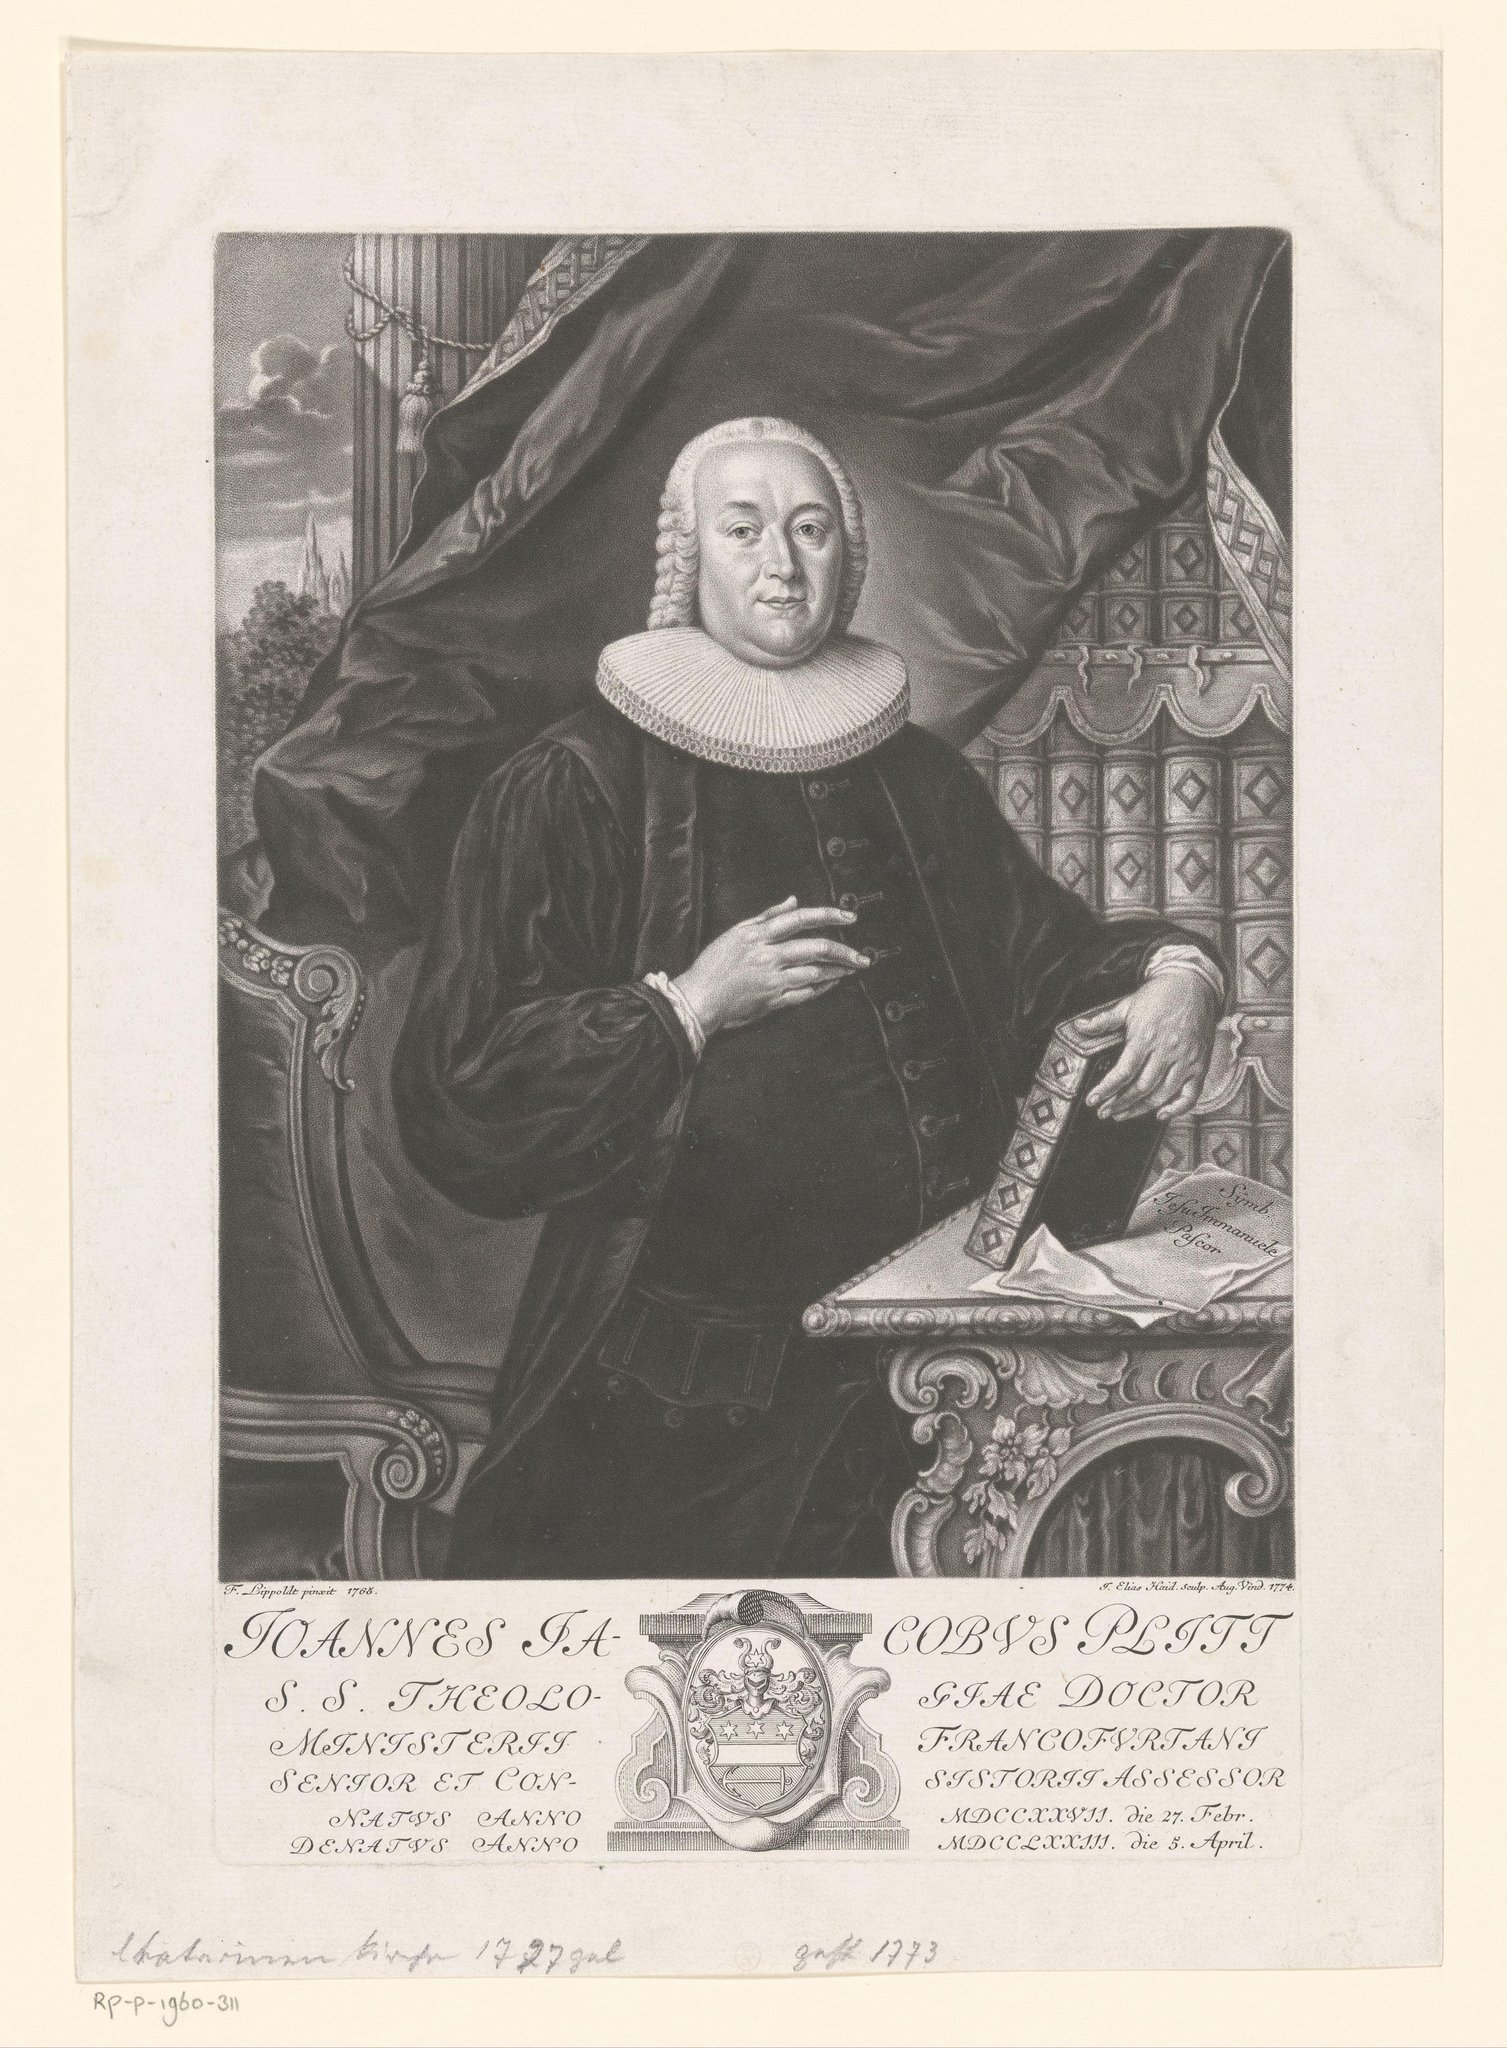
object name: print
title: Portret van Johann Jakob Plitt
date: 1765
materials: paper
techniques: mezzotint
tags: bookshelves, theologian, historical persons, book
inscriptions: collector's mark: Lugt 2228